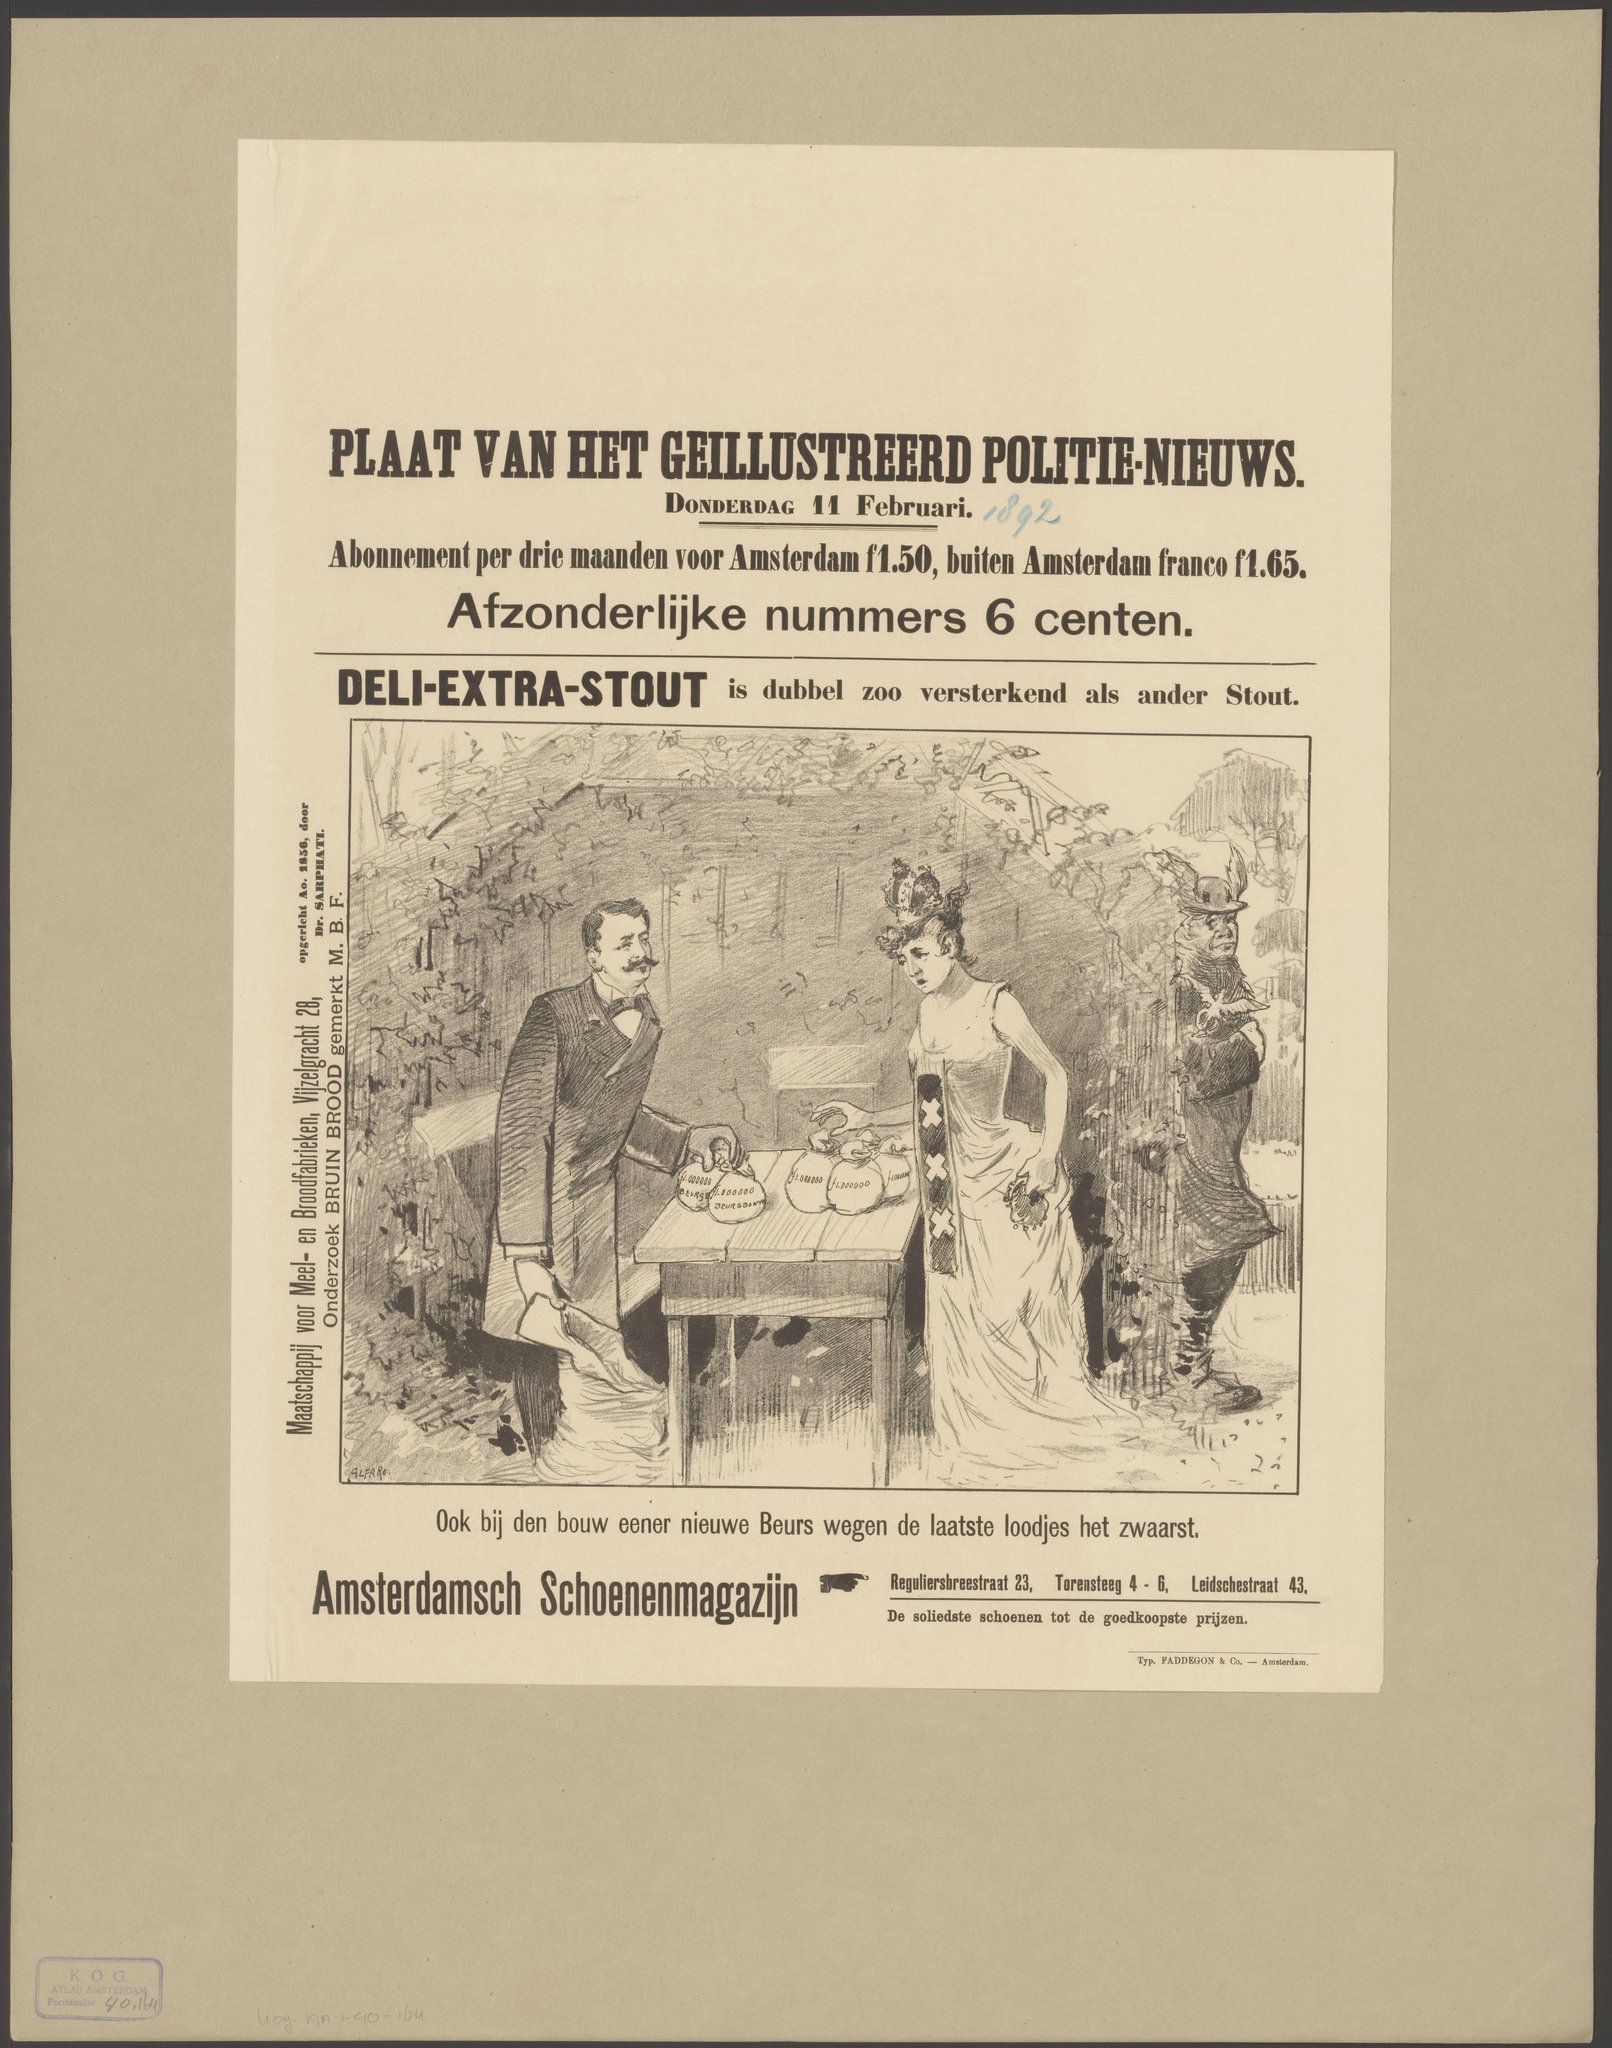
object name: print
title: Ook bij den bouw eener nieuwe Beurs wegen de laatste loodjes het zwaarst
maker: alfaro reijding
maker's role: draughtsman, engineer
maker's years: 1863-1930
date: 1892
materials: paper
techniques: letterpress printing, lithograph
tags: stock exchange, stock-market, amsterdam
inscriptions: collector's mark: Lugt 1641b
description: Onderwerpsrubriek binnen de Atlas Amsterdam: Handel en Zeevaart, E. Spotprenten betreffende de Beurs.